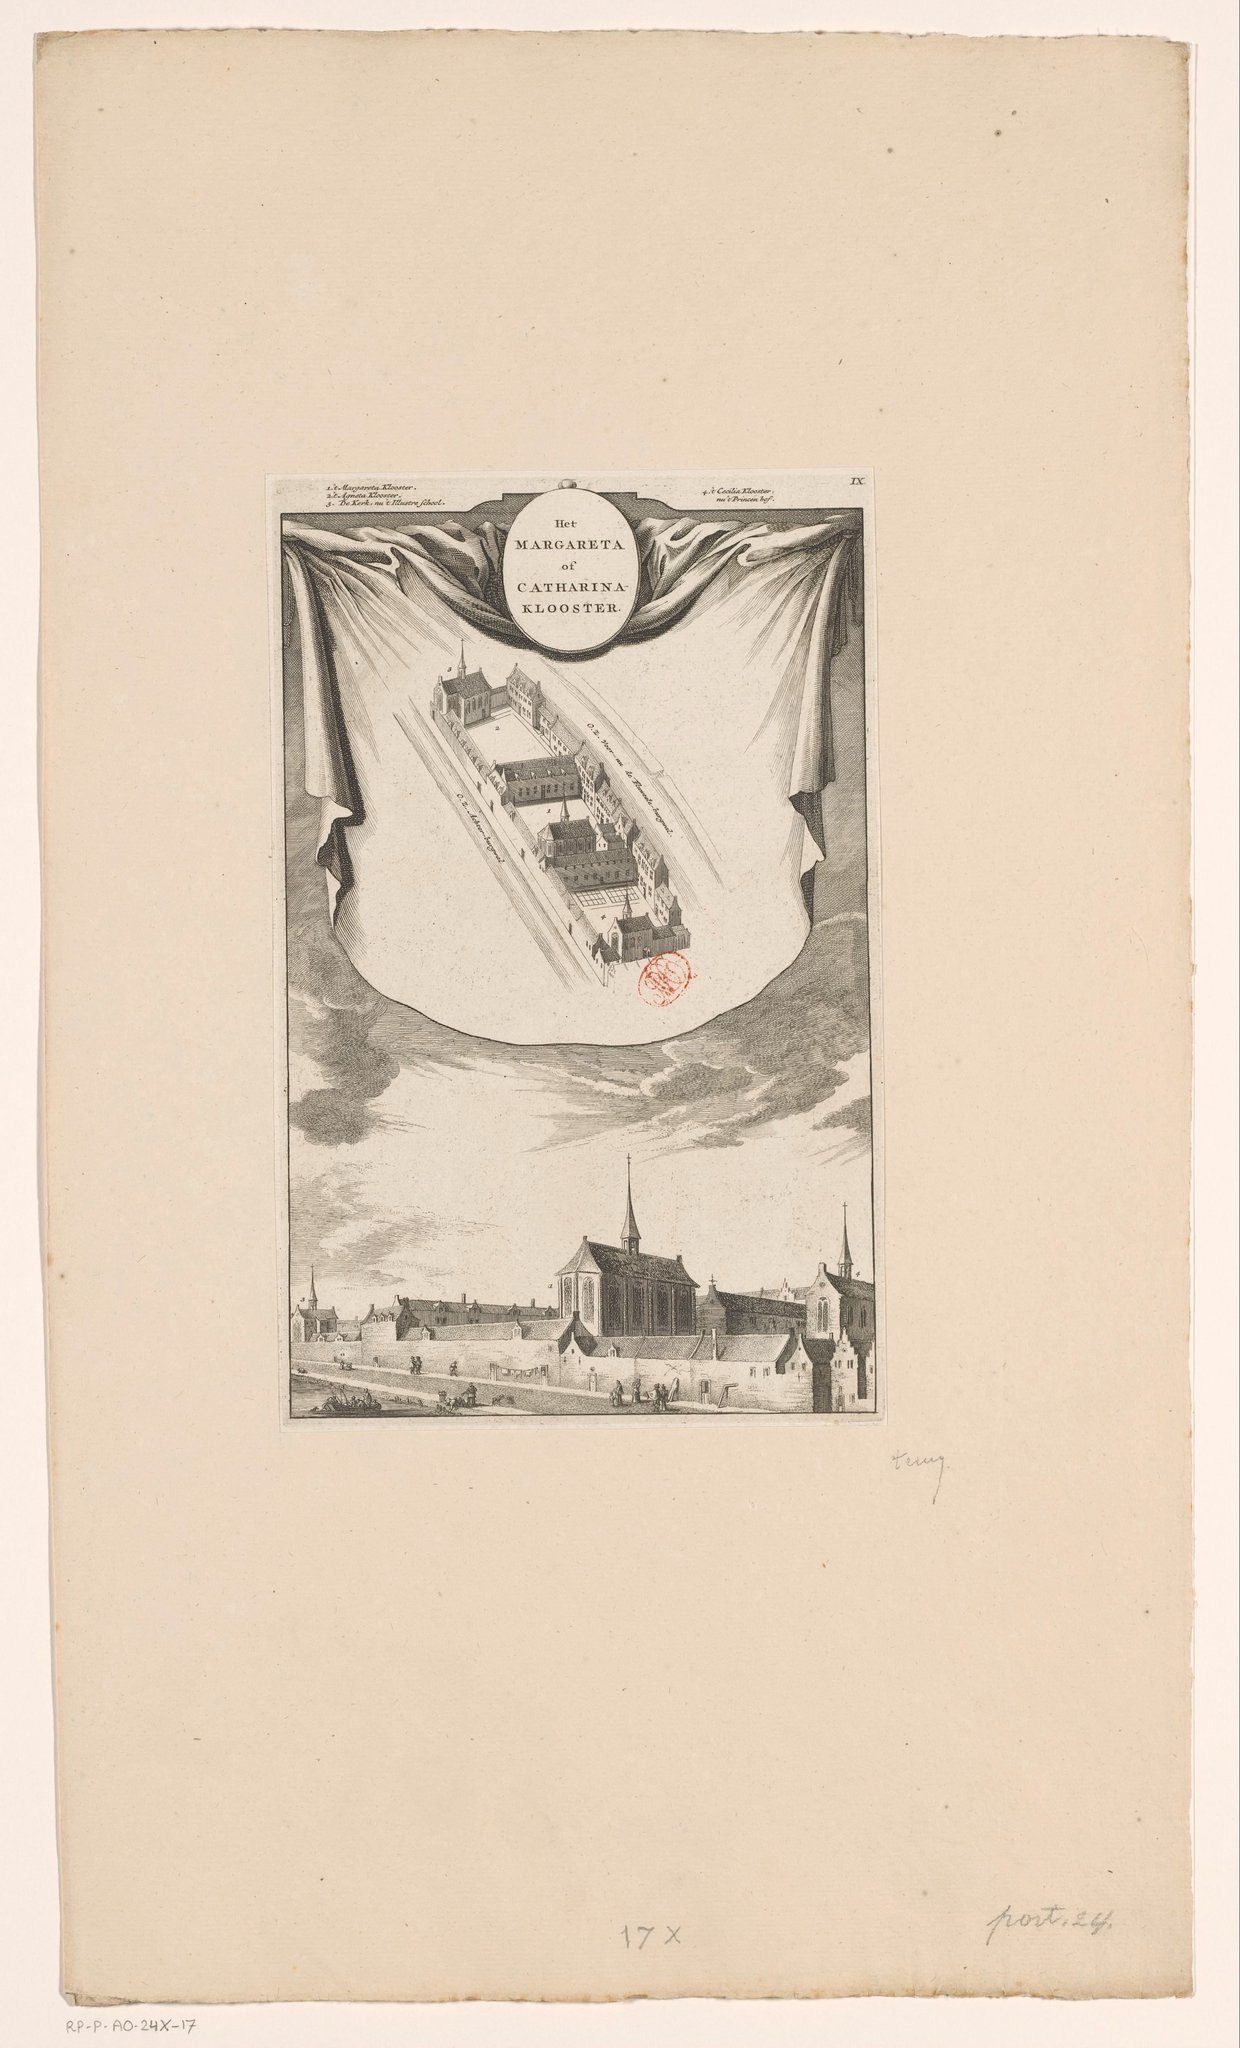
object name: book illustration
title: Gezichten op het Sint-Catharinaklooster te Amsterdam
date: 1760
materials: paper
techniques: engraving, etching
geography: amsterdam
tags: abbey, monastery, convent ~ roman catholic church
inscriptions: collector's mark: Lugt 195, collector's mark: Lugt 2233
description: Prent ook gebruikt in: Wagenaar, Jan. Amsterdam, in zyne opkomst, aanwas, geschiedenissen (…). 3 delen [folio-uitgave]. Amsterdam: Isaak Tirion en Yntema & Tieboel, 1760-1767, dl. 1 (Isaac Tirion, 1760). Zie RP-P-AO-24X-18 voor proefdruk. Dat de prent de situatie rond 1544 weergeeft gaat terug op het feit dat voor het maken van deze en andere prenten van kloosters en kerken van voor de Alteratie (1578) is uitgegaan van de plattegrond van Cornelis Anthonisz. uit 1544 (zie RP-P-OB-70.399 en RP-P-AO-20-15).